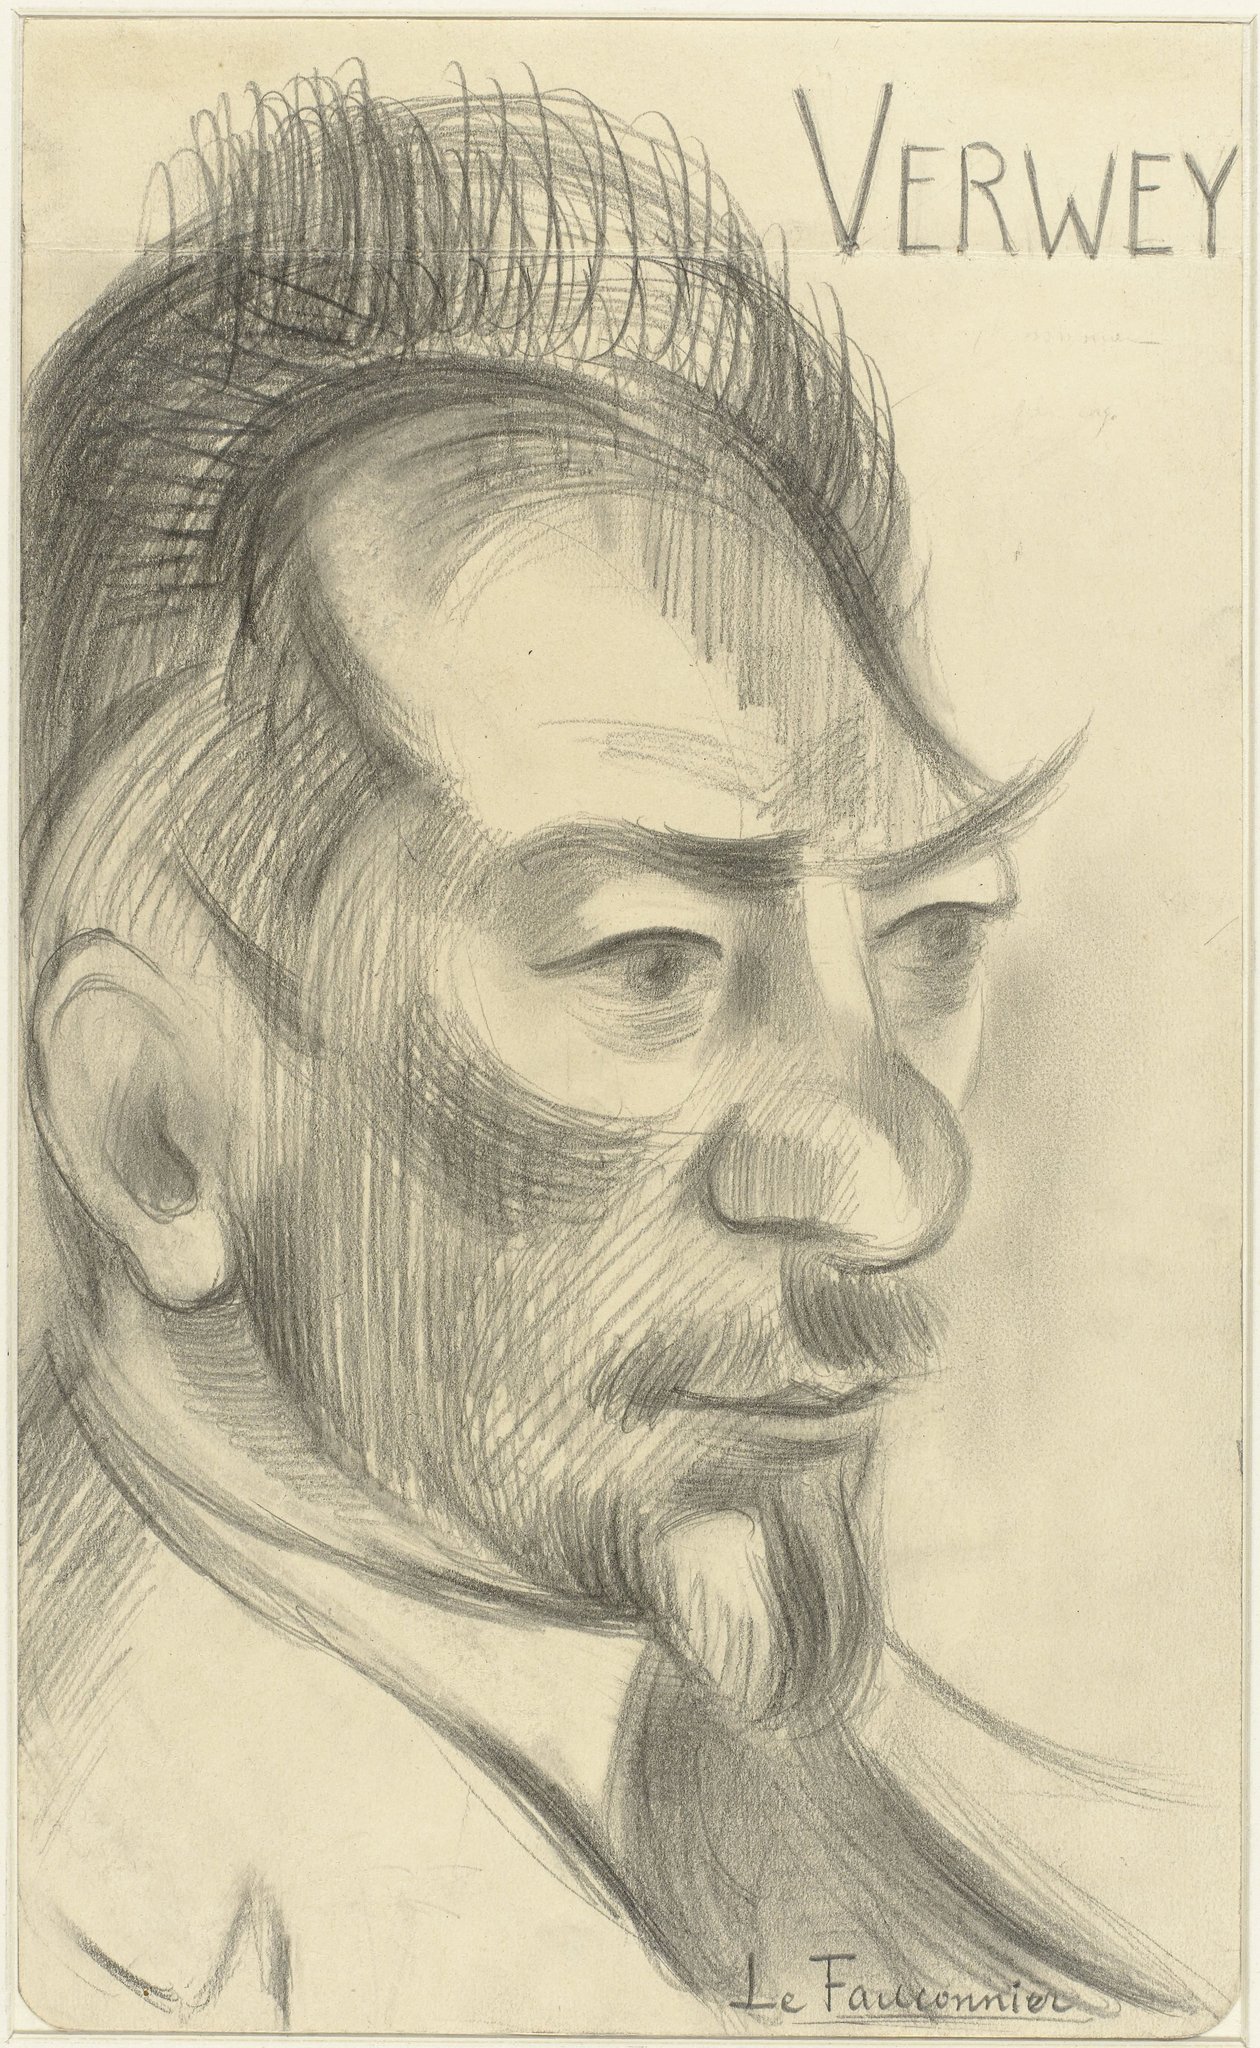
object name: drawing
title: Portret van de schrijver Albert Verwey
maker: henri victor gabriel le fauconnier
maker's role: painter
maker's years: 1881-1945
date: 1918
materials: paper, pencil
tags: amsterdam, albert verwey, historical persons, portrait of a writer, portrait, self-portrait of artist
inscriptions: signature: ‘Le Fauconnier’, date, inscription